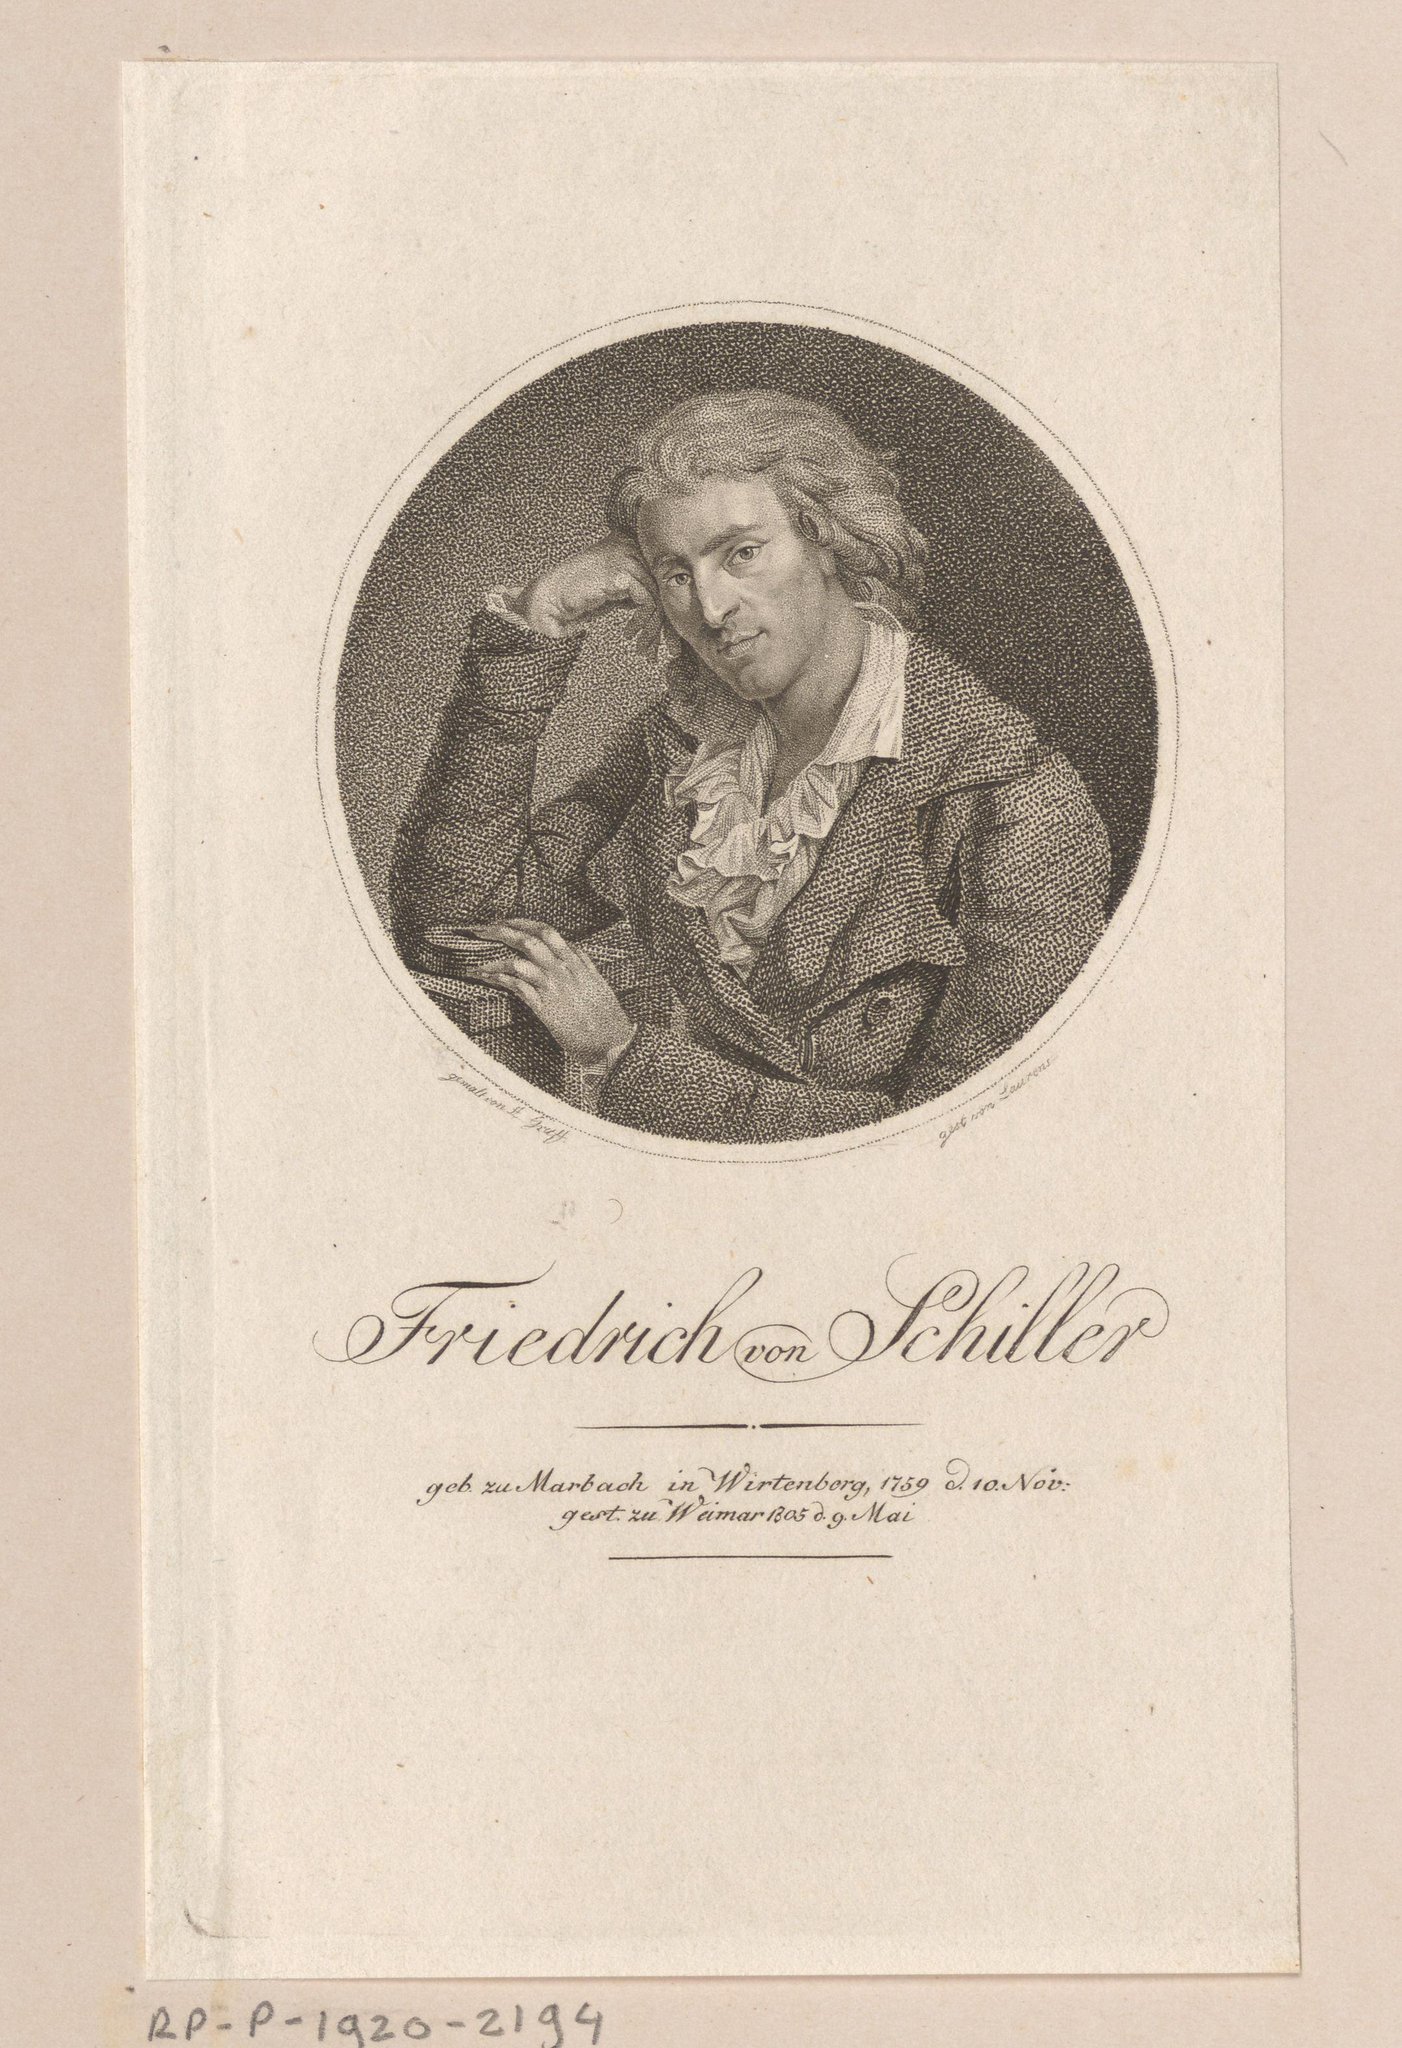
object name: print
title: Portret van Friedrich von Schiller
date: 1805-1832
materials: paper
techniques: engraving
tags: friedrich von schiller, scholar, philosopher, historical persons, portrait of a writer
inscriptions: collector's mark: Lugt 2228